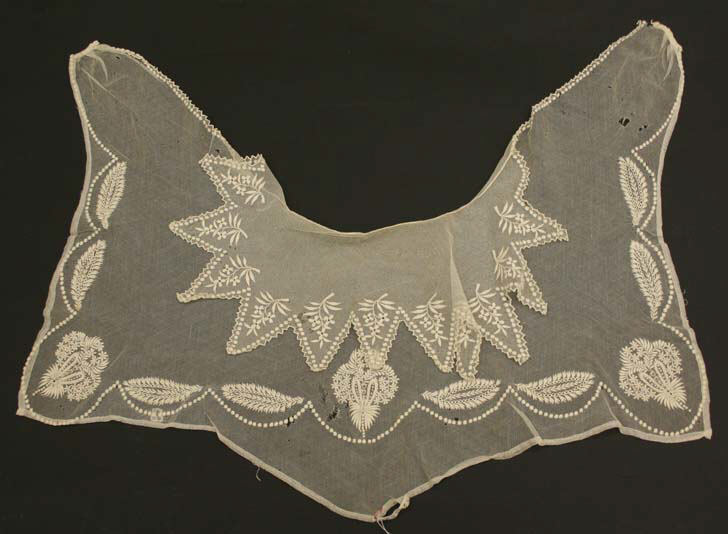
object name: fichu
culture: european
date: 1700-1938